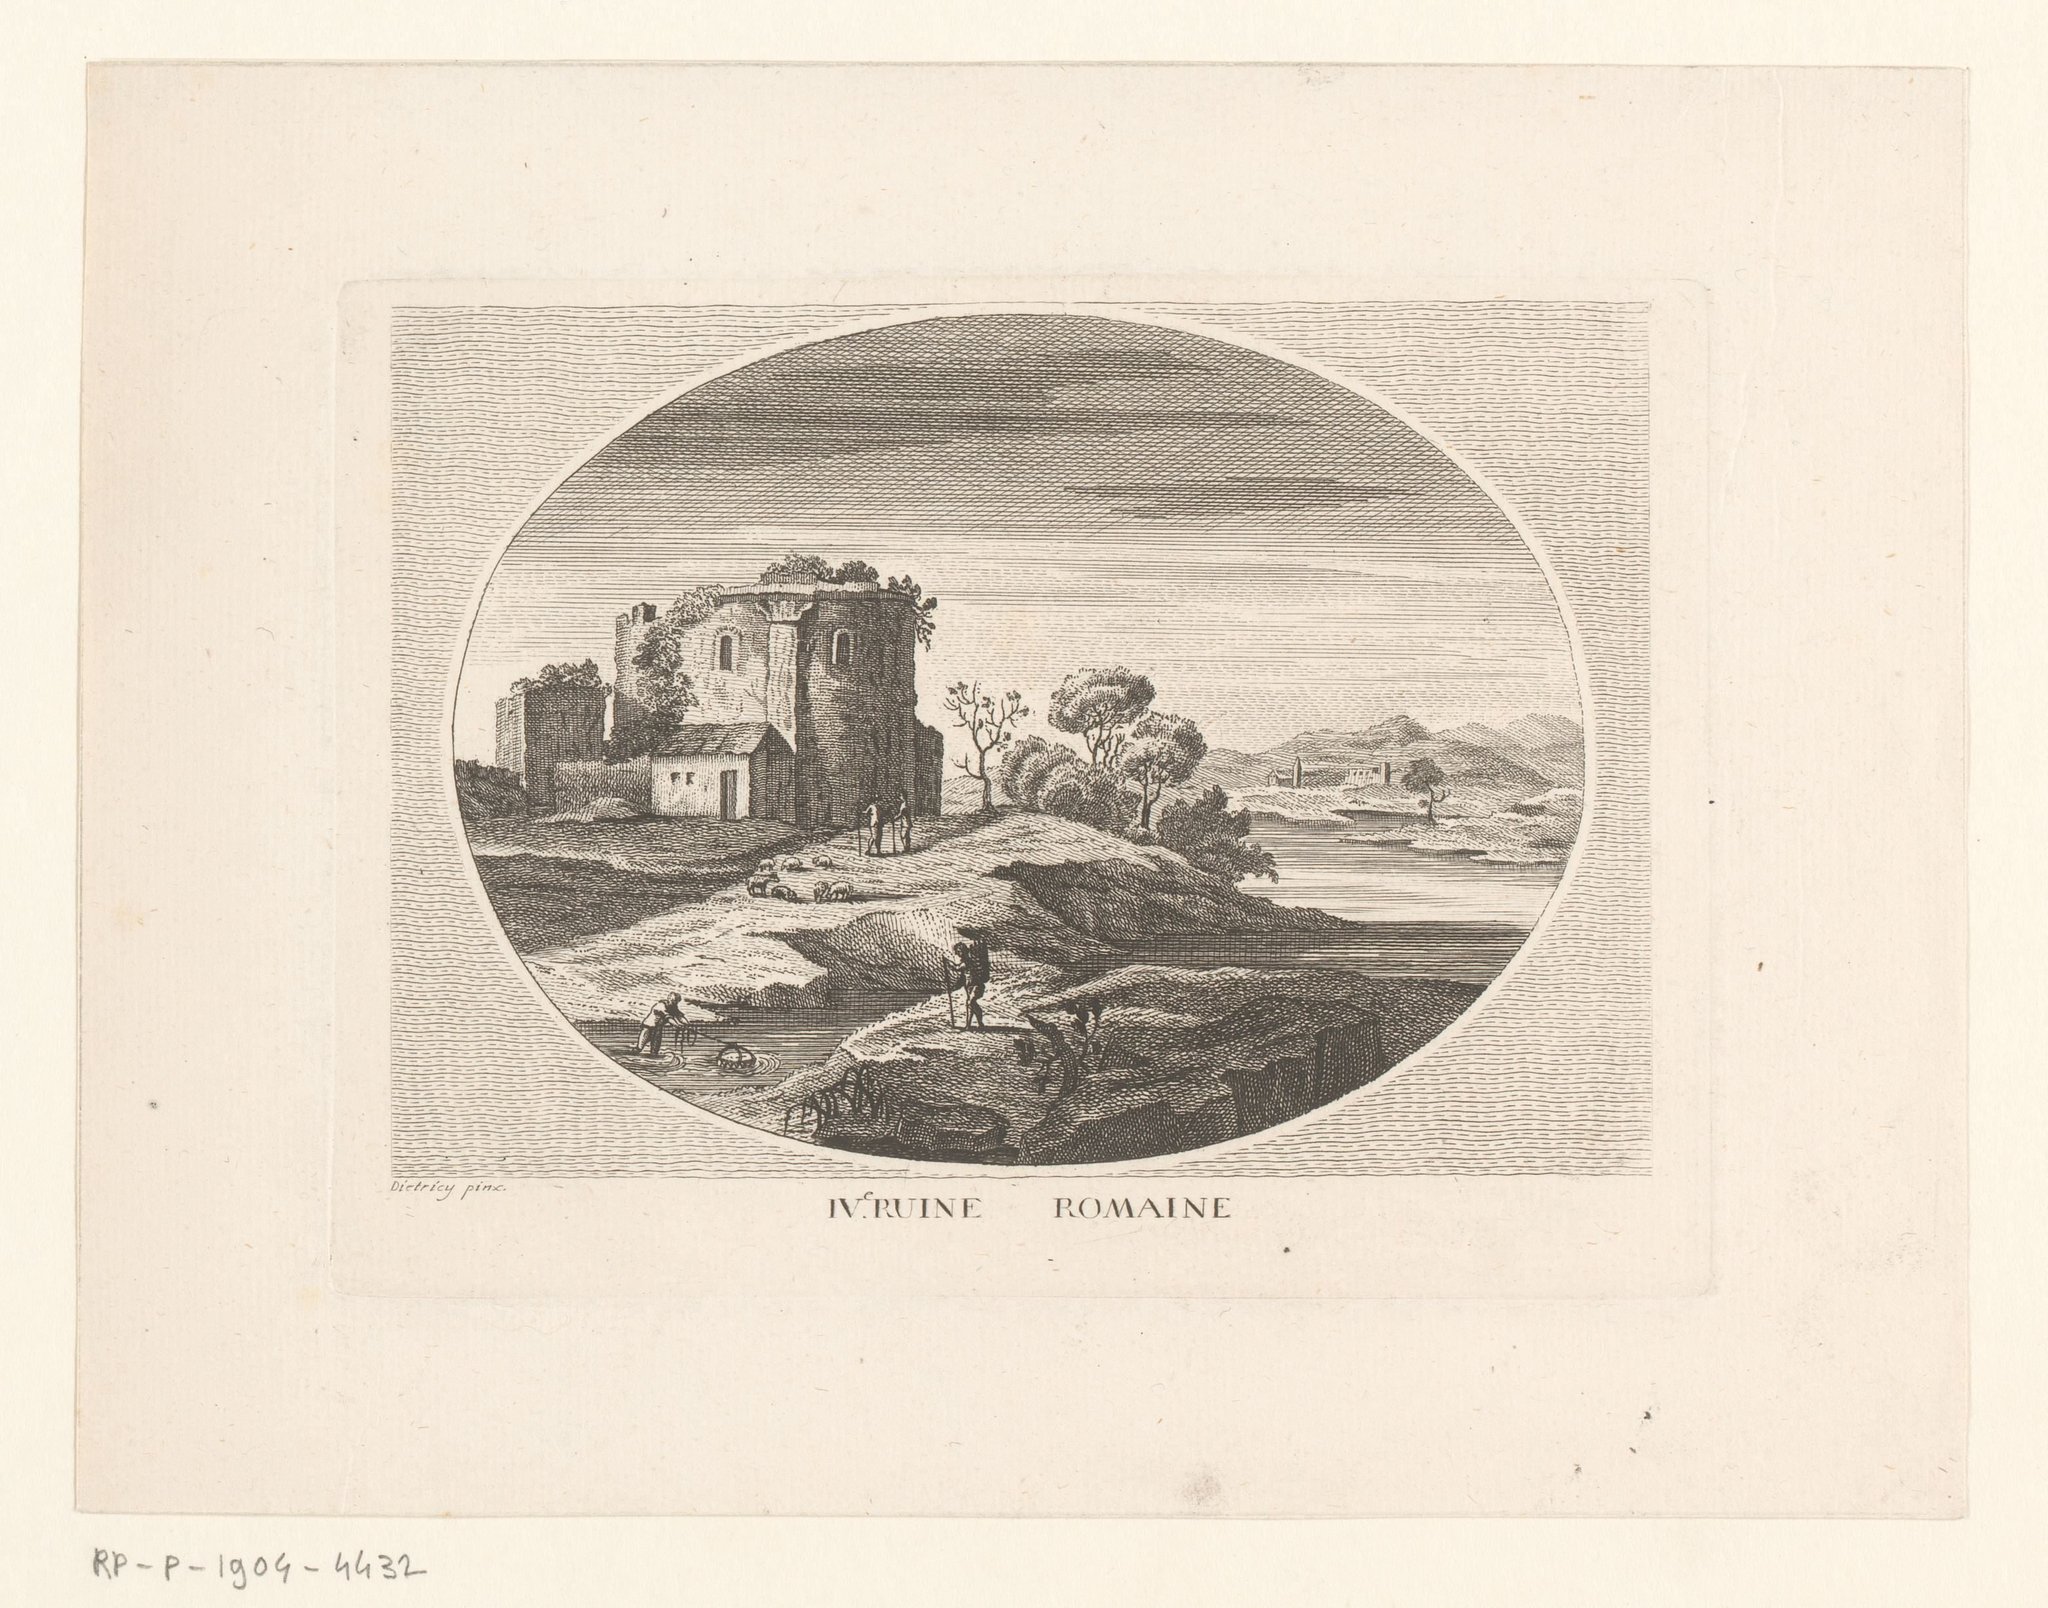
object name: print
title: IVe Ruine romaine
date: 1722-1822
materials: paper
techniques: engraving, etching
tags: landscape with ruins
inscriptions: collector's mark: Lugt 2228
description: Maakt waarschijnlijk deel uit van een onbekende serie met Romeinse ruïnes.